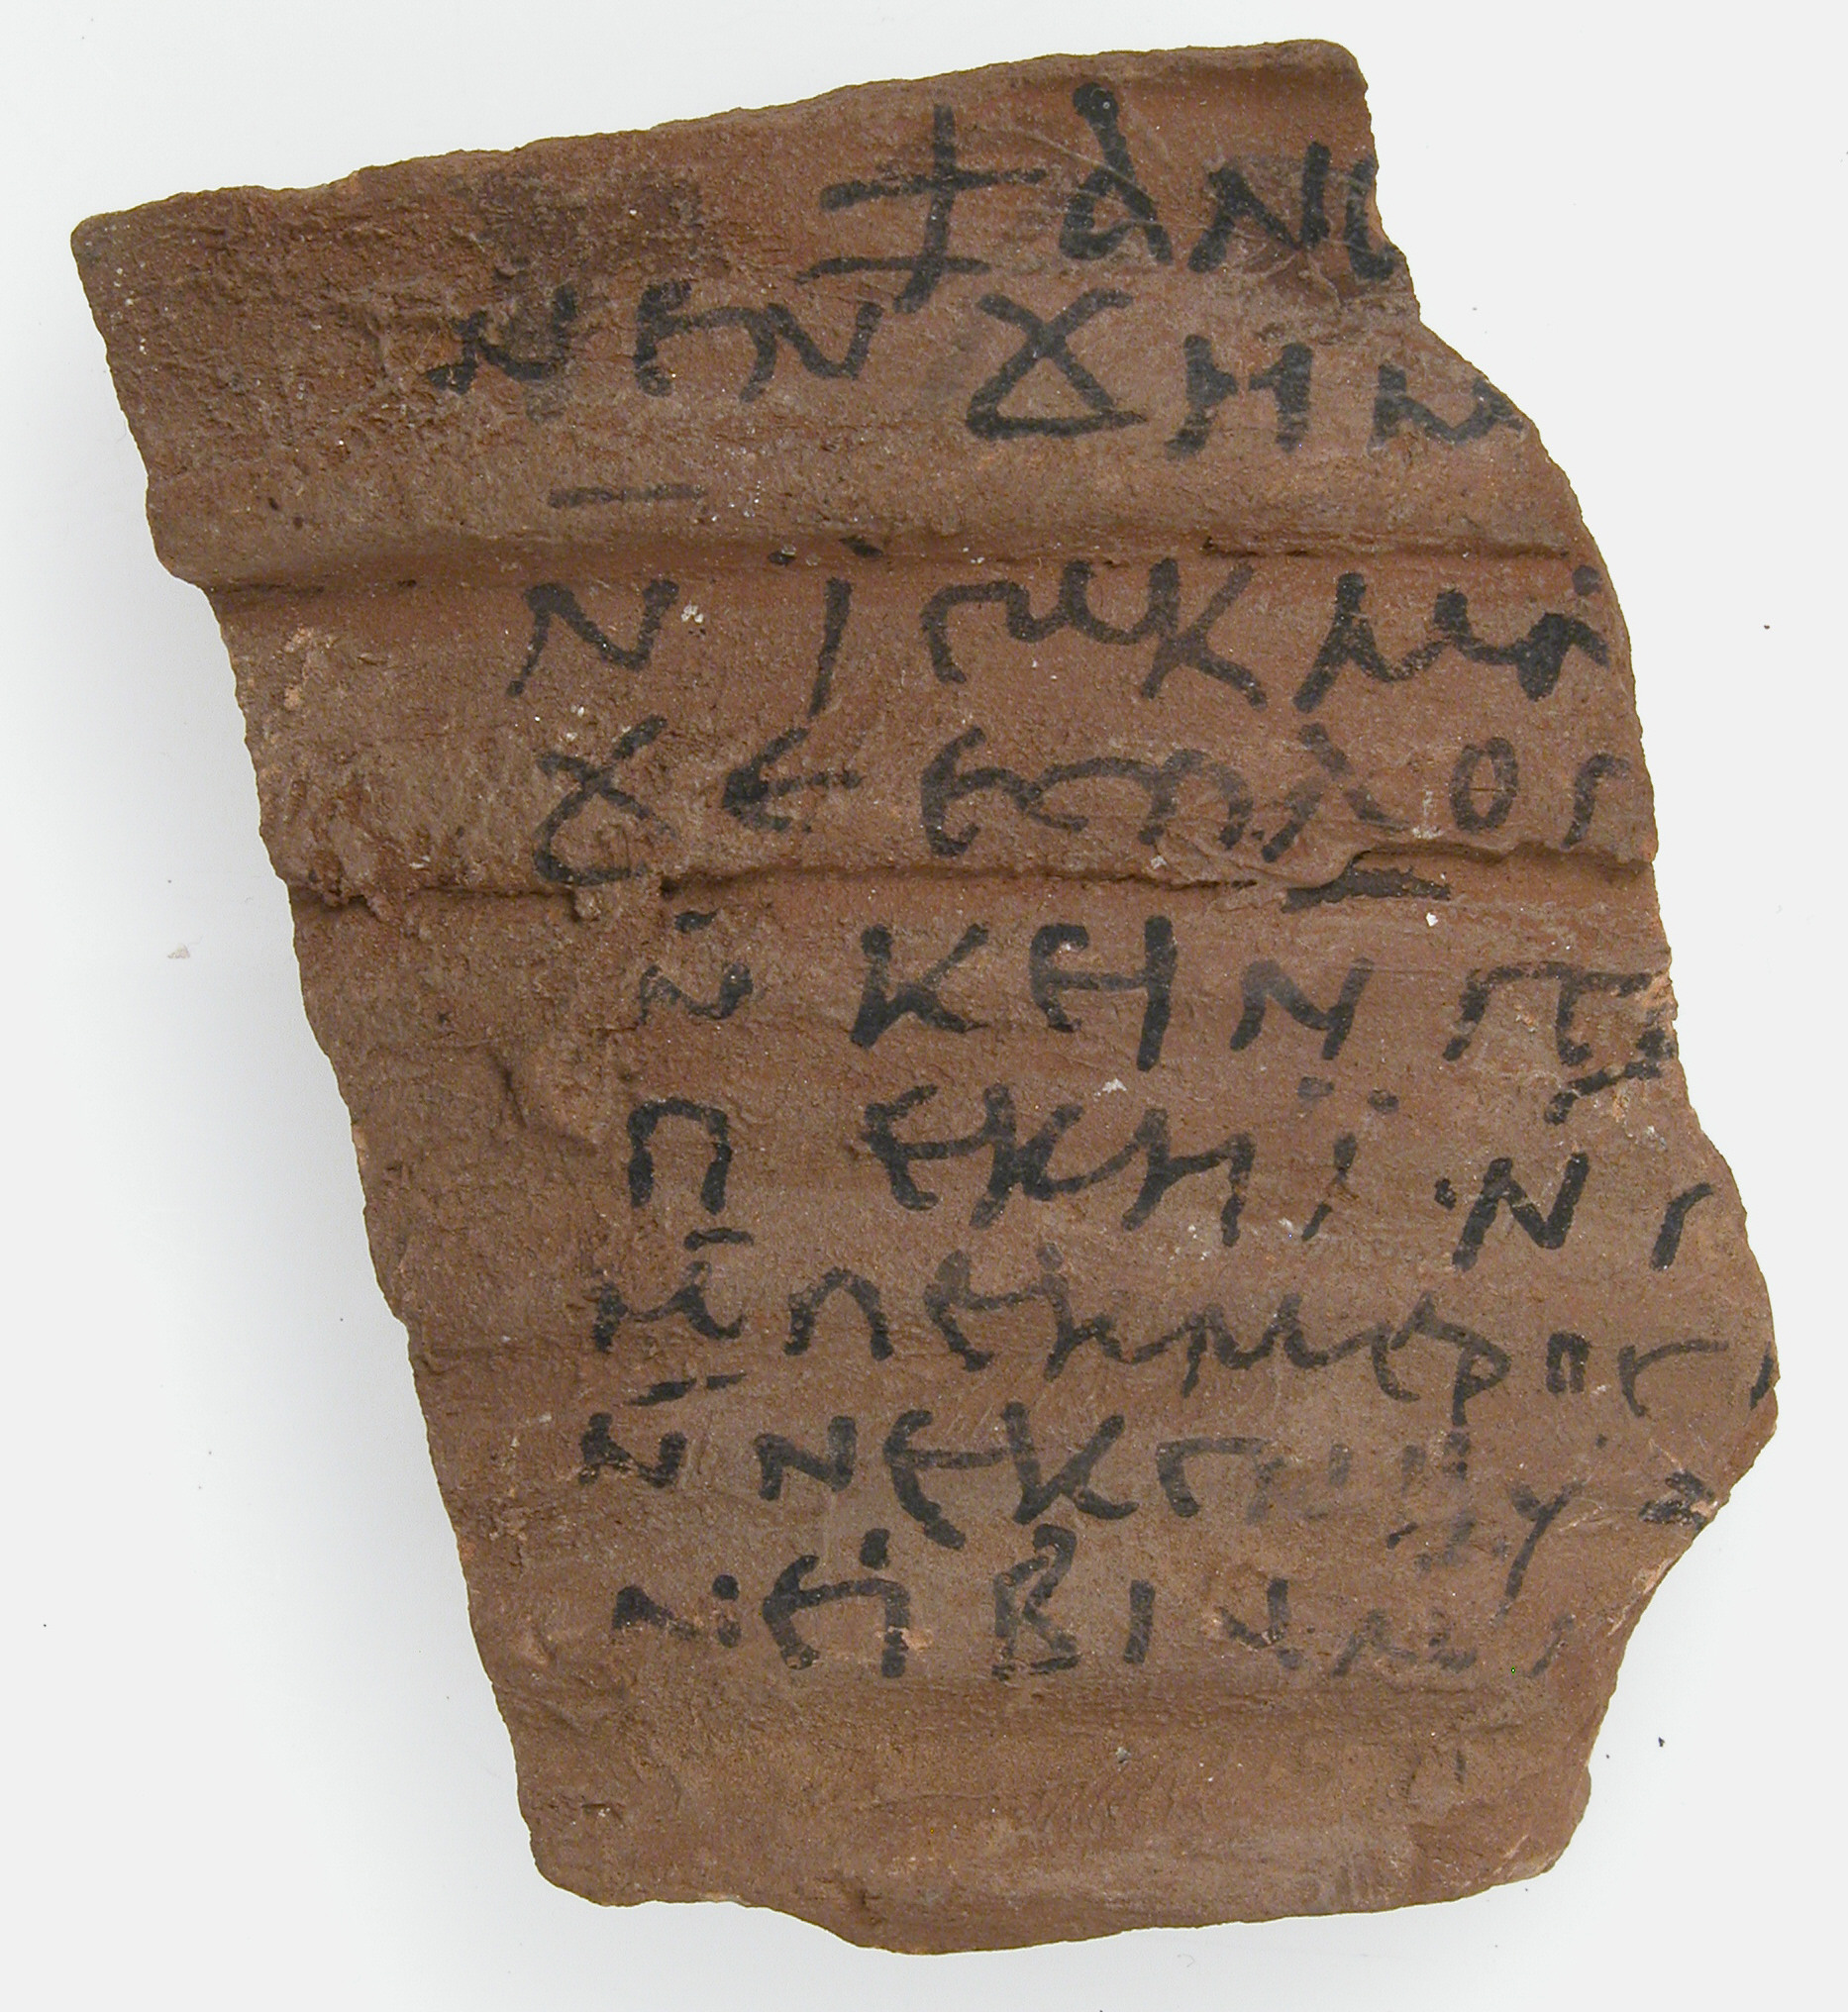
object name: ostrakon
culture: coptic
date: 601-700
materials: ink, pottery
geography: egypt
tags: coptic